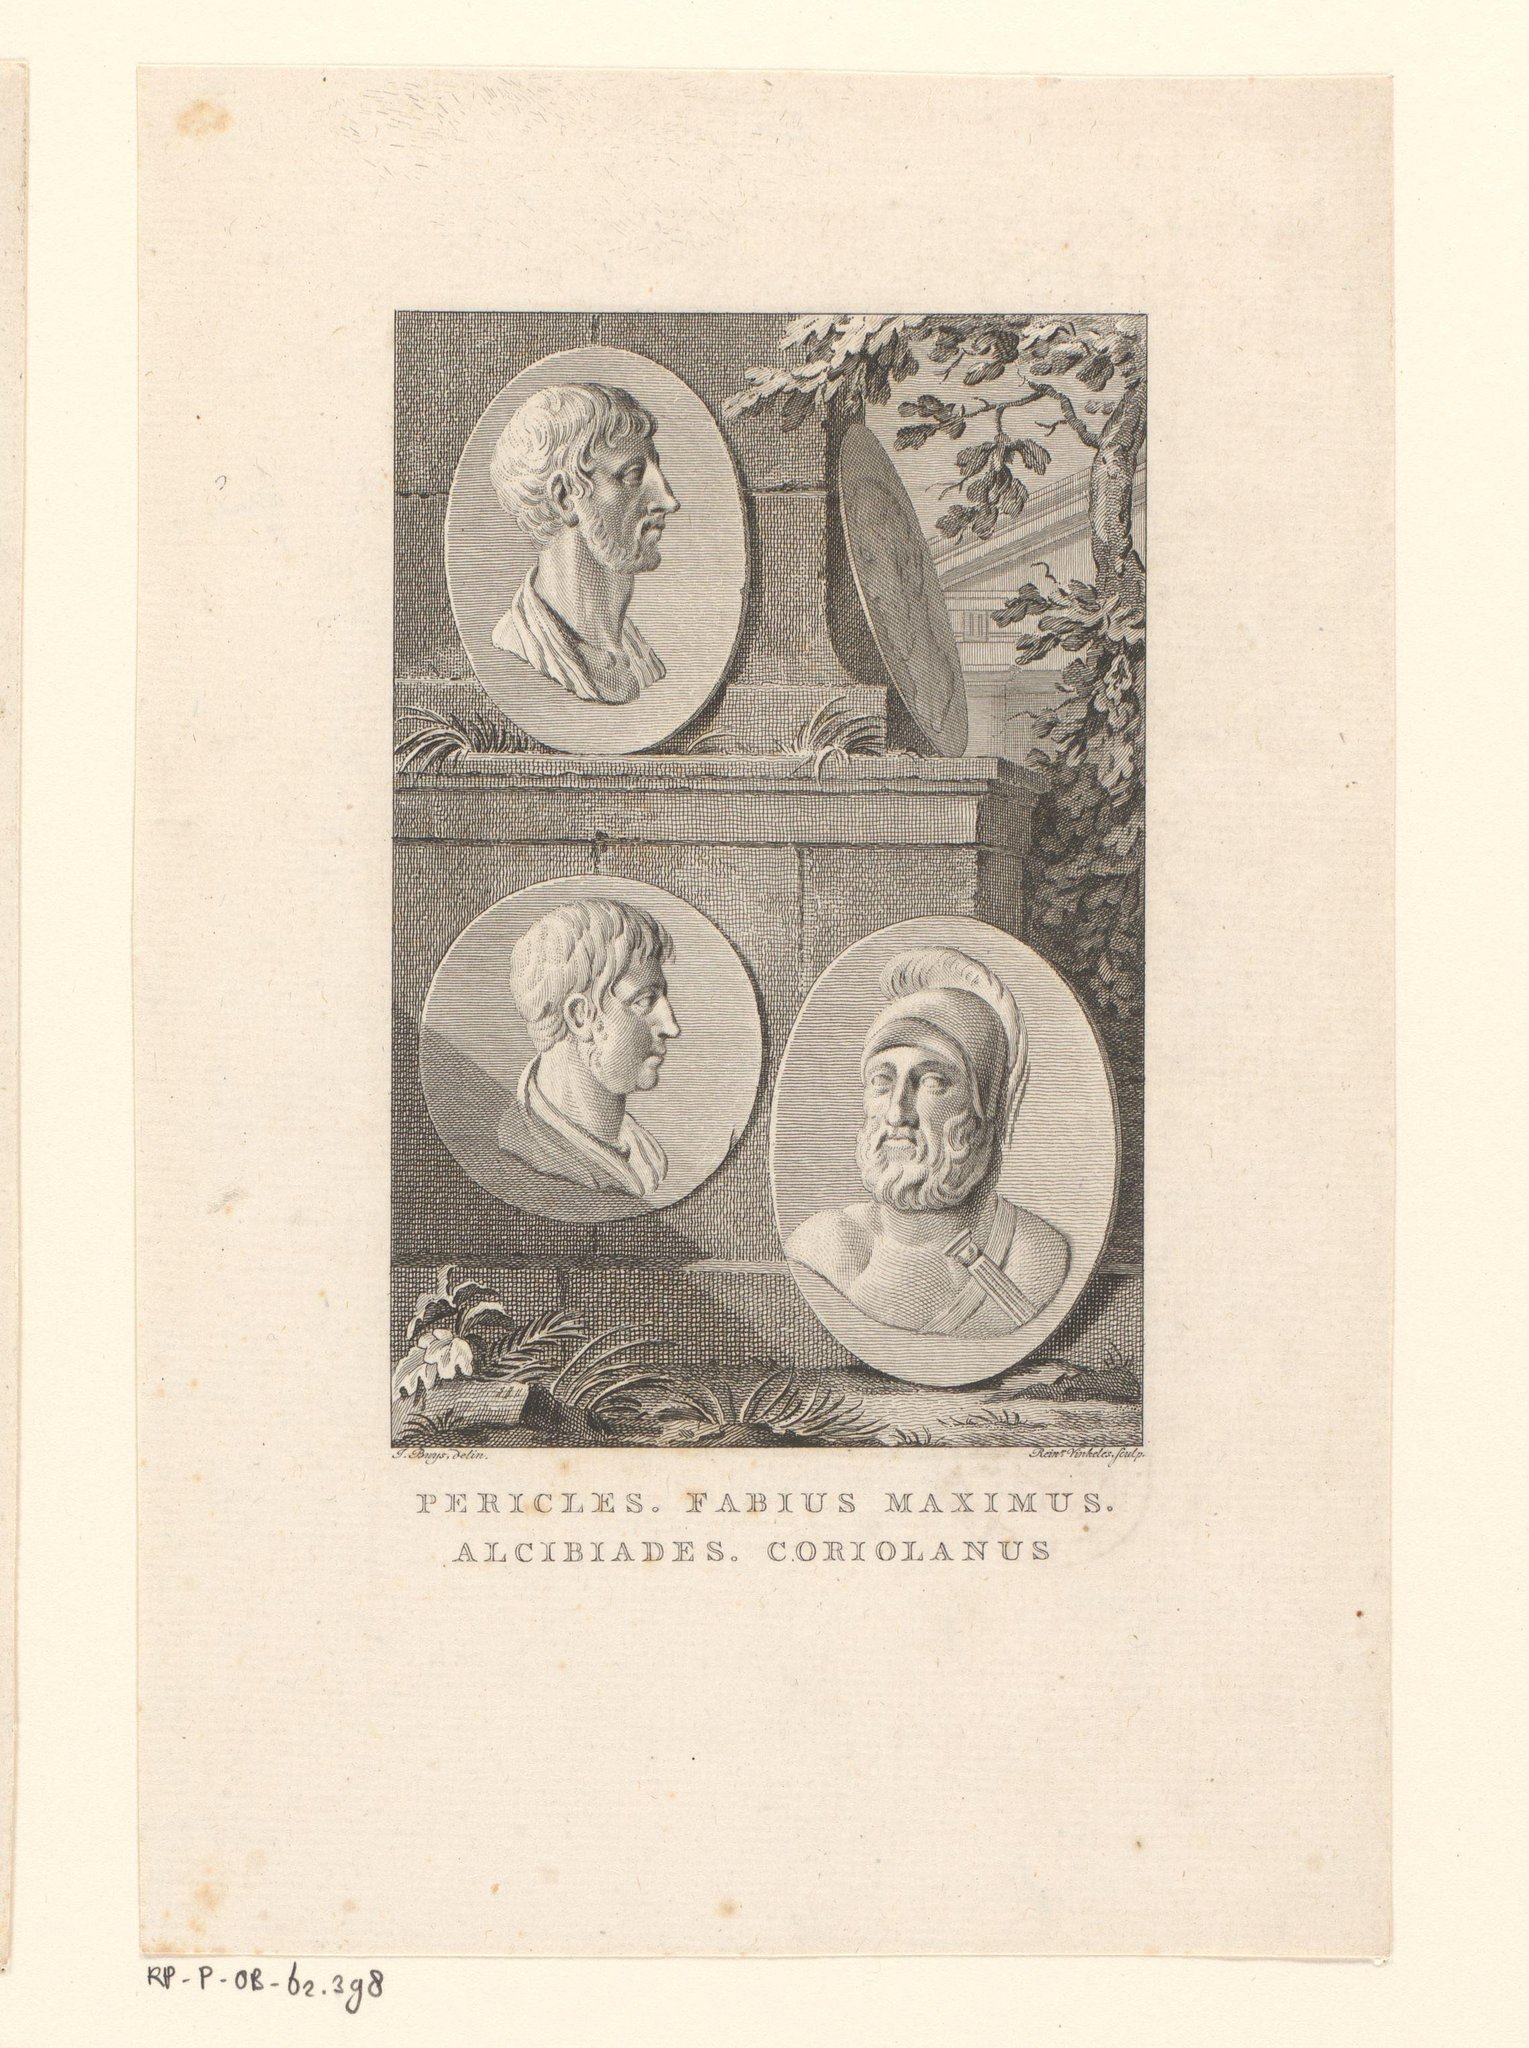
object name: print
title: Medaillons met portretten van Pericles, Fabius Maximus, Alcibiades en Coriolanus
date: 1789-1809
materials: paper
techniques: etching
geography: amsterdam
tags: (story of) alcibiades, (story of) coriolanus, (story of) quintus fabius maximus cunctator, (story of) pericles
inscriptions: collector's mark: Lugt 240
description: Prent ook gebruikt als boekillustratie in: Plutarchus [bewerkt door E. Wassenbergh en H. Bosscha]. De levens van doorluchtige Grieken en Romeinen, onderling vergeleeken (...). 12 dln. Amsterdam: Johannes Allart, 1789-1809.